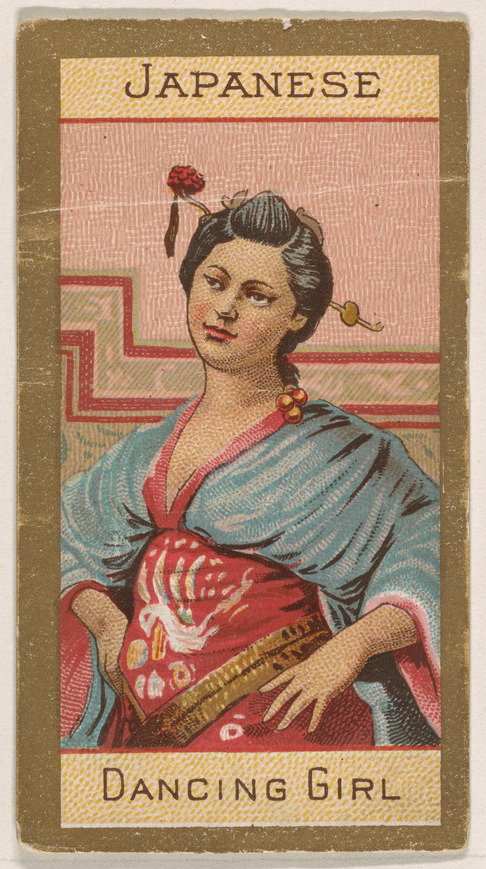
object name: print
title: Japanese, Dancing Girl, from Types of Nationalities (N240) issued by Kinney Bros.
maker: kinney brothers tobacco company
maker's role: publisher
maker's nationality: american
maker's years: 1869-2011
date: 1890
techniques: color lithograph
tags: girls,dancing